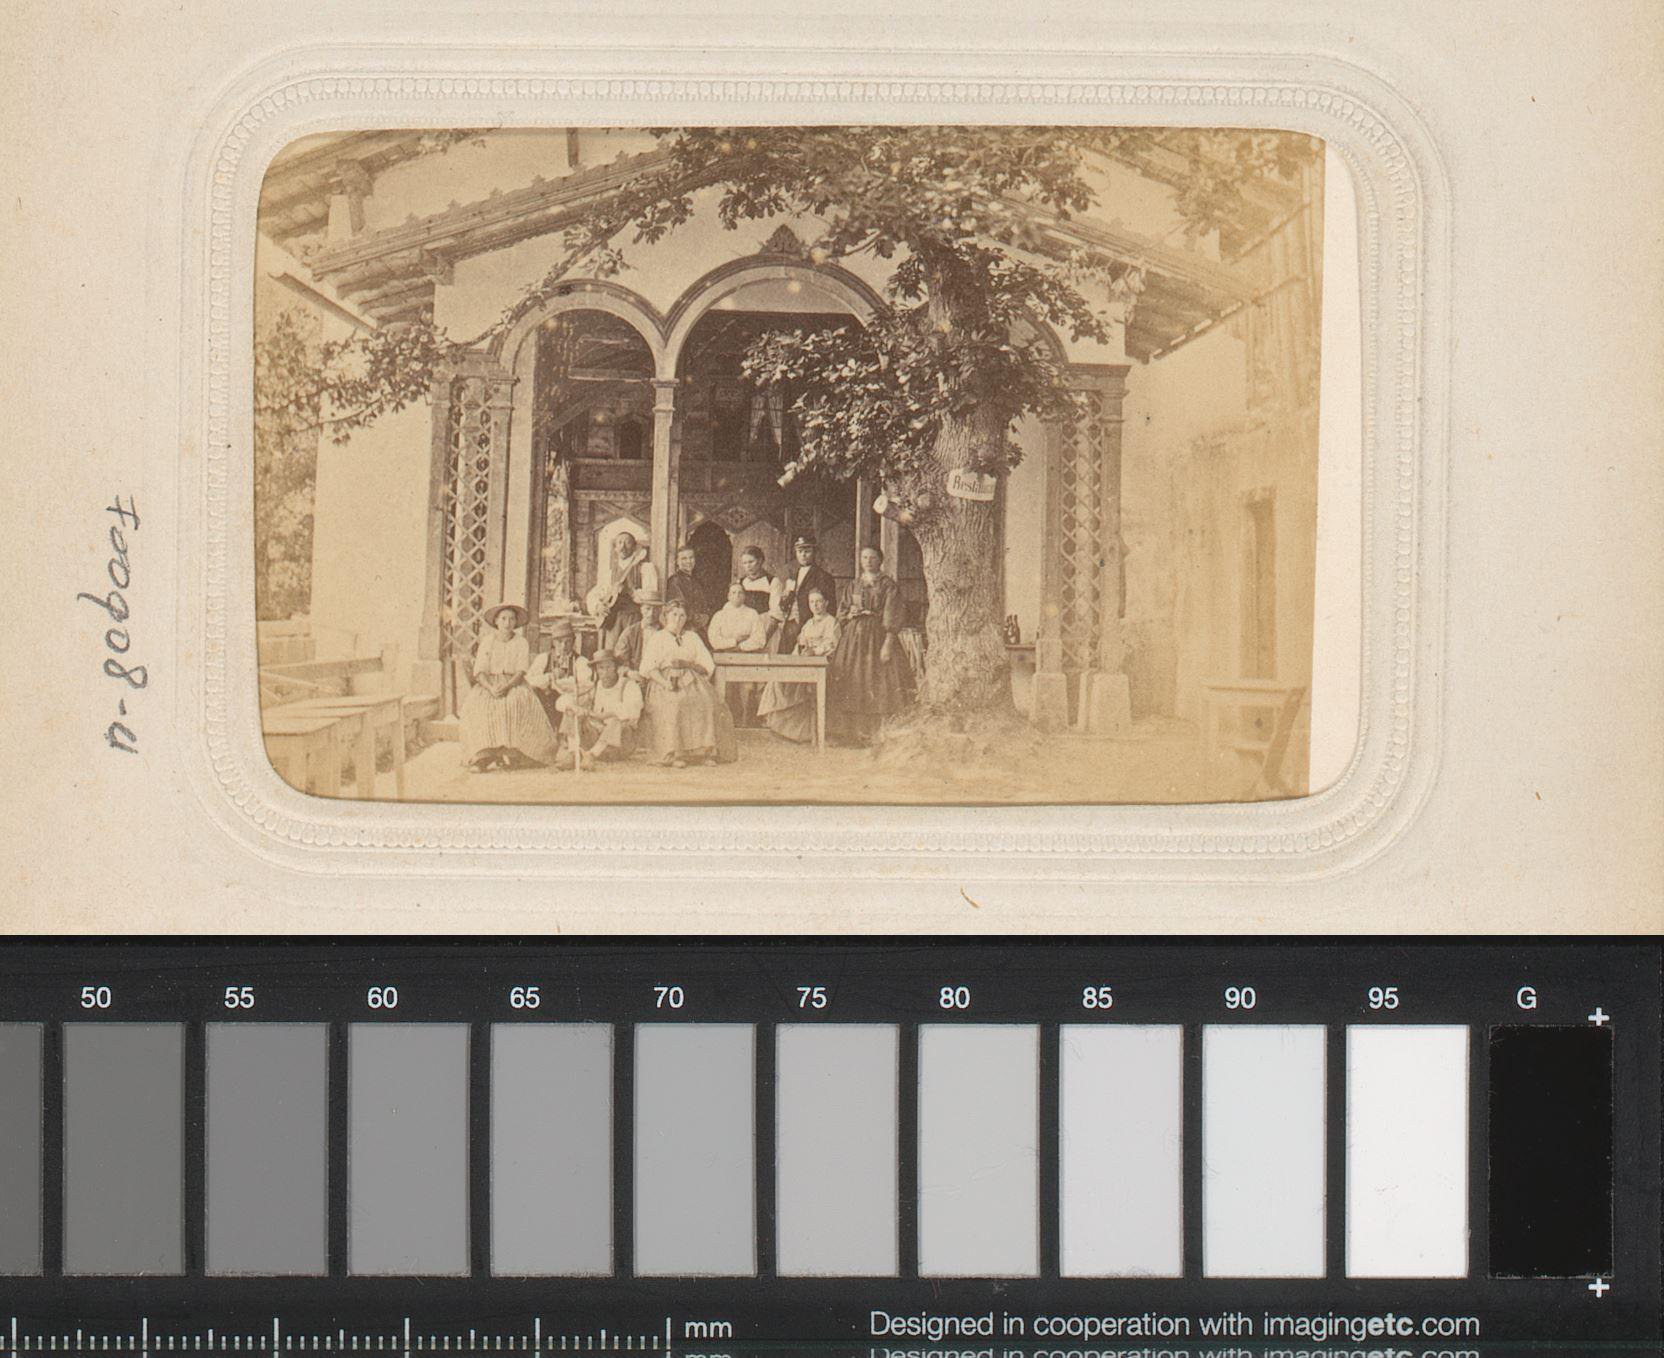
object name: album leaf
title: Groepsportret op terras voor een restaurant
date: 1860-1890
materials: cardboard, photographic support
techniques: albumen print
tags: trees, anonymous historical persons portrayed in a group, in a group-portrait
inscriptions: inscription: ‘Photographie en tous genres/ Wolff & Nicola/ Rue du Christof No. 186 E/ Berne’